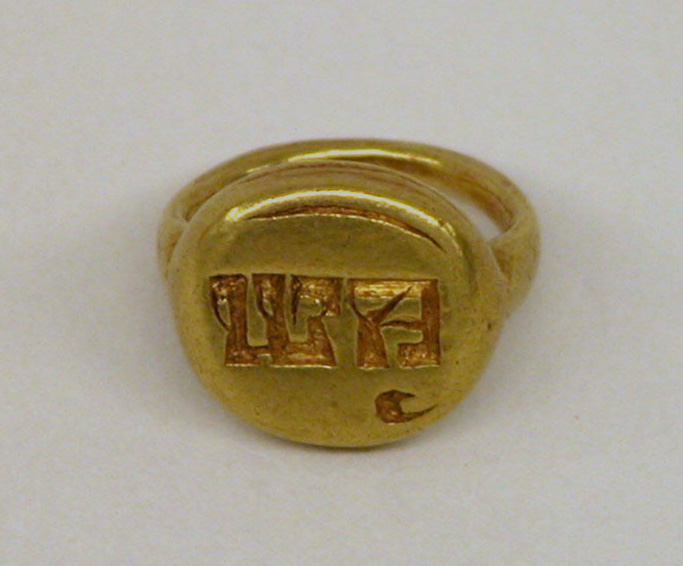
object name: ring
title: Ring with Circular Bezel with "Java Kuno" Inscription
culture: indonesian, javanese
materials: gold